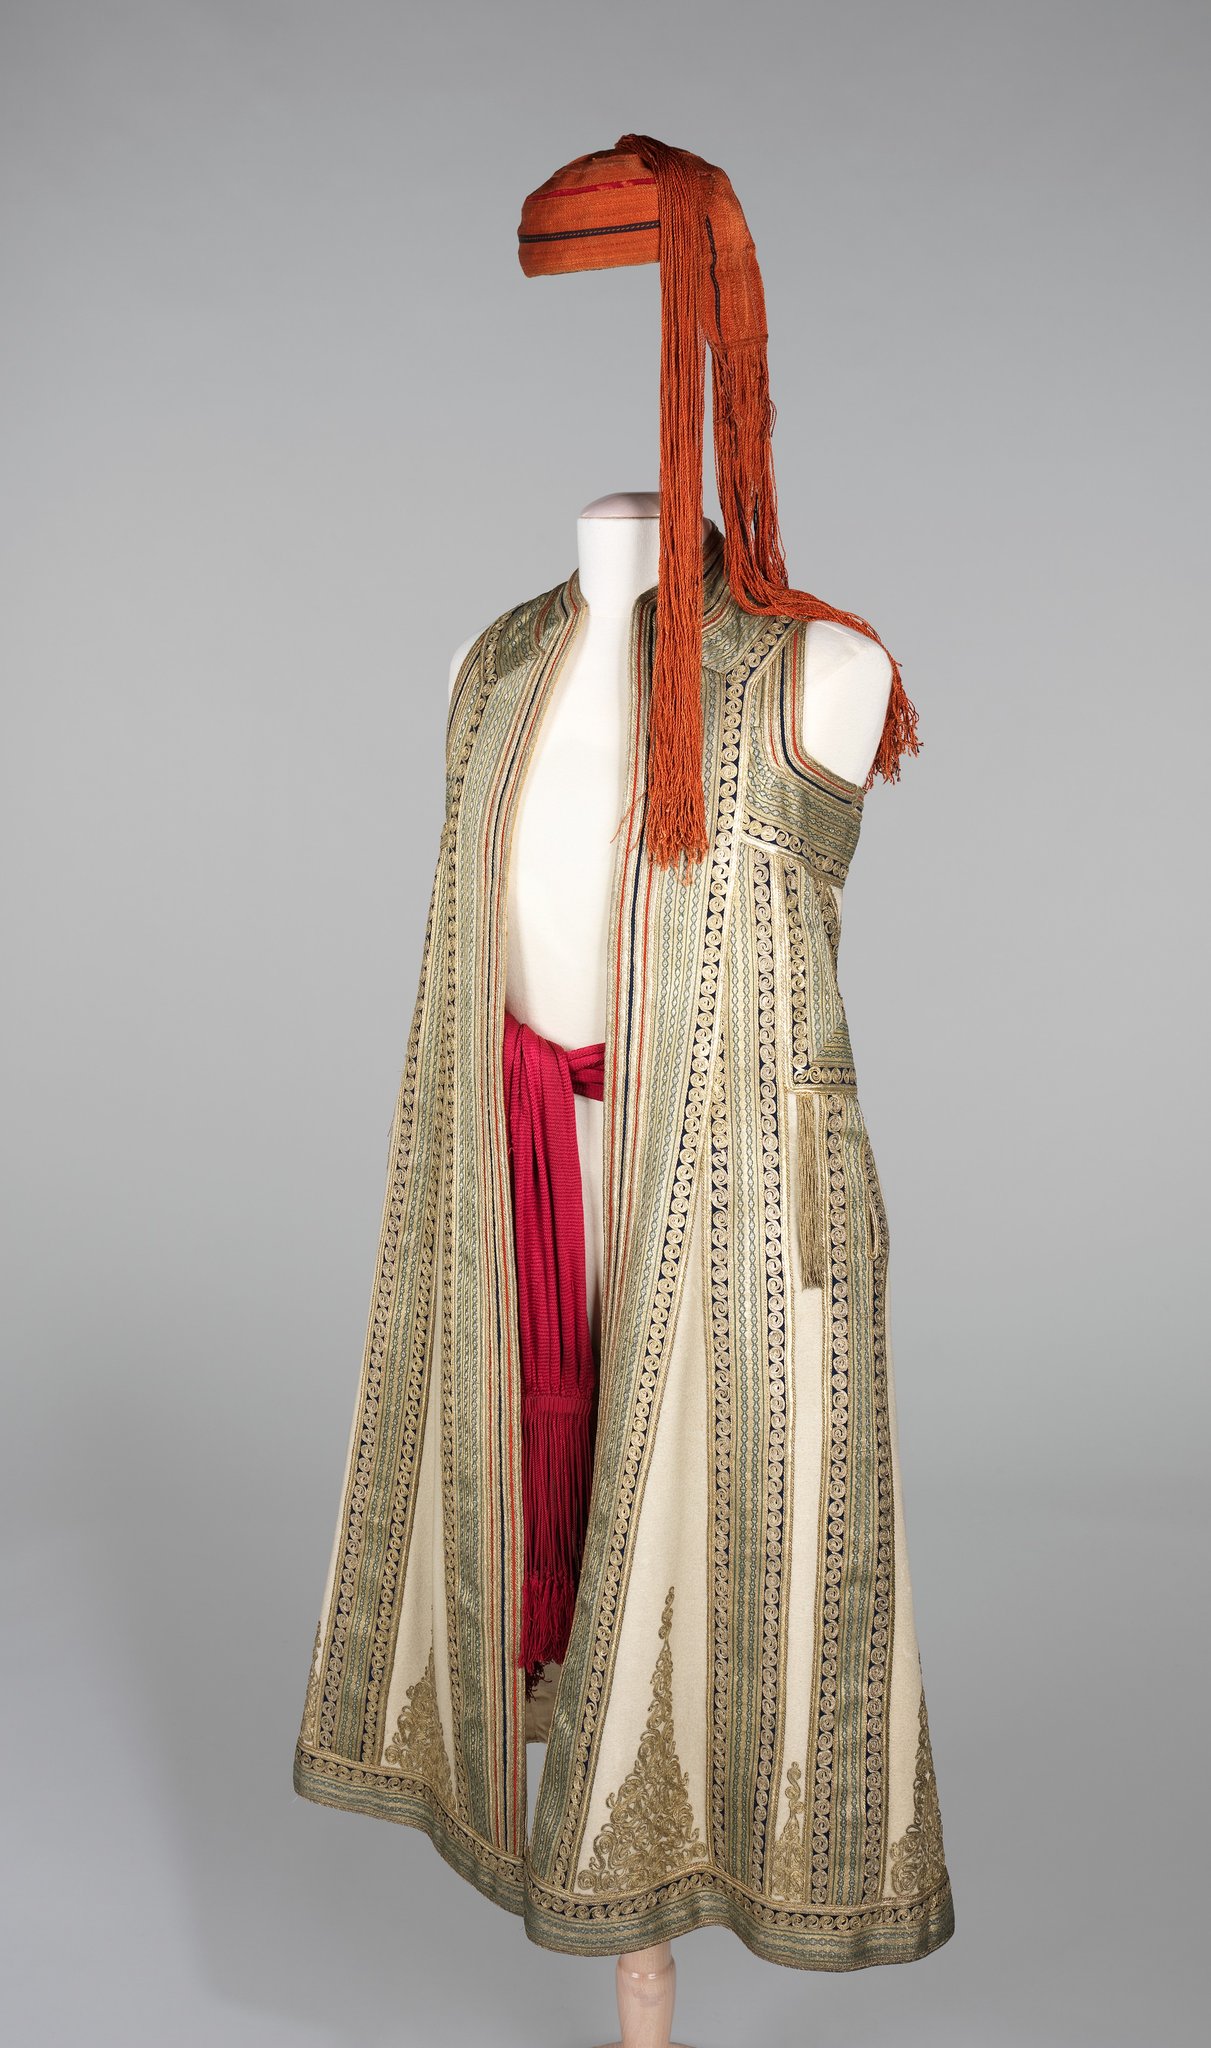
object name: ensemble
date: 1876-1900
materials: cotton, metal, silk, wool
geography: albania